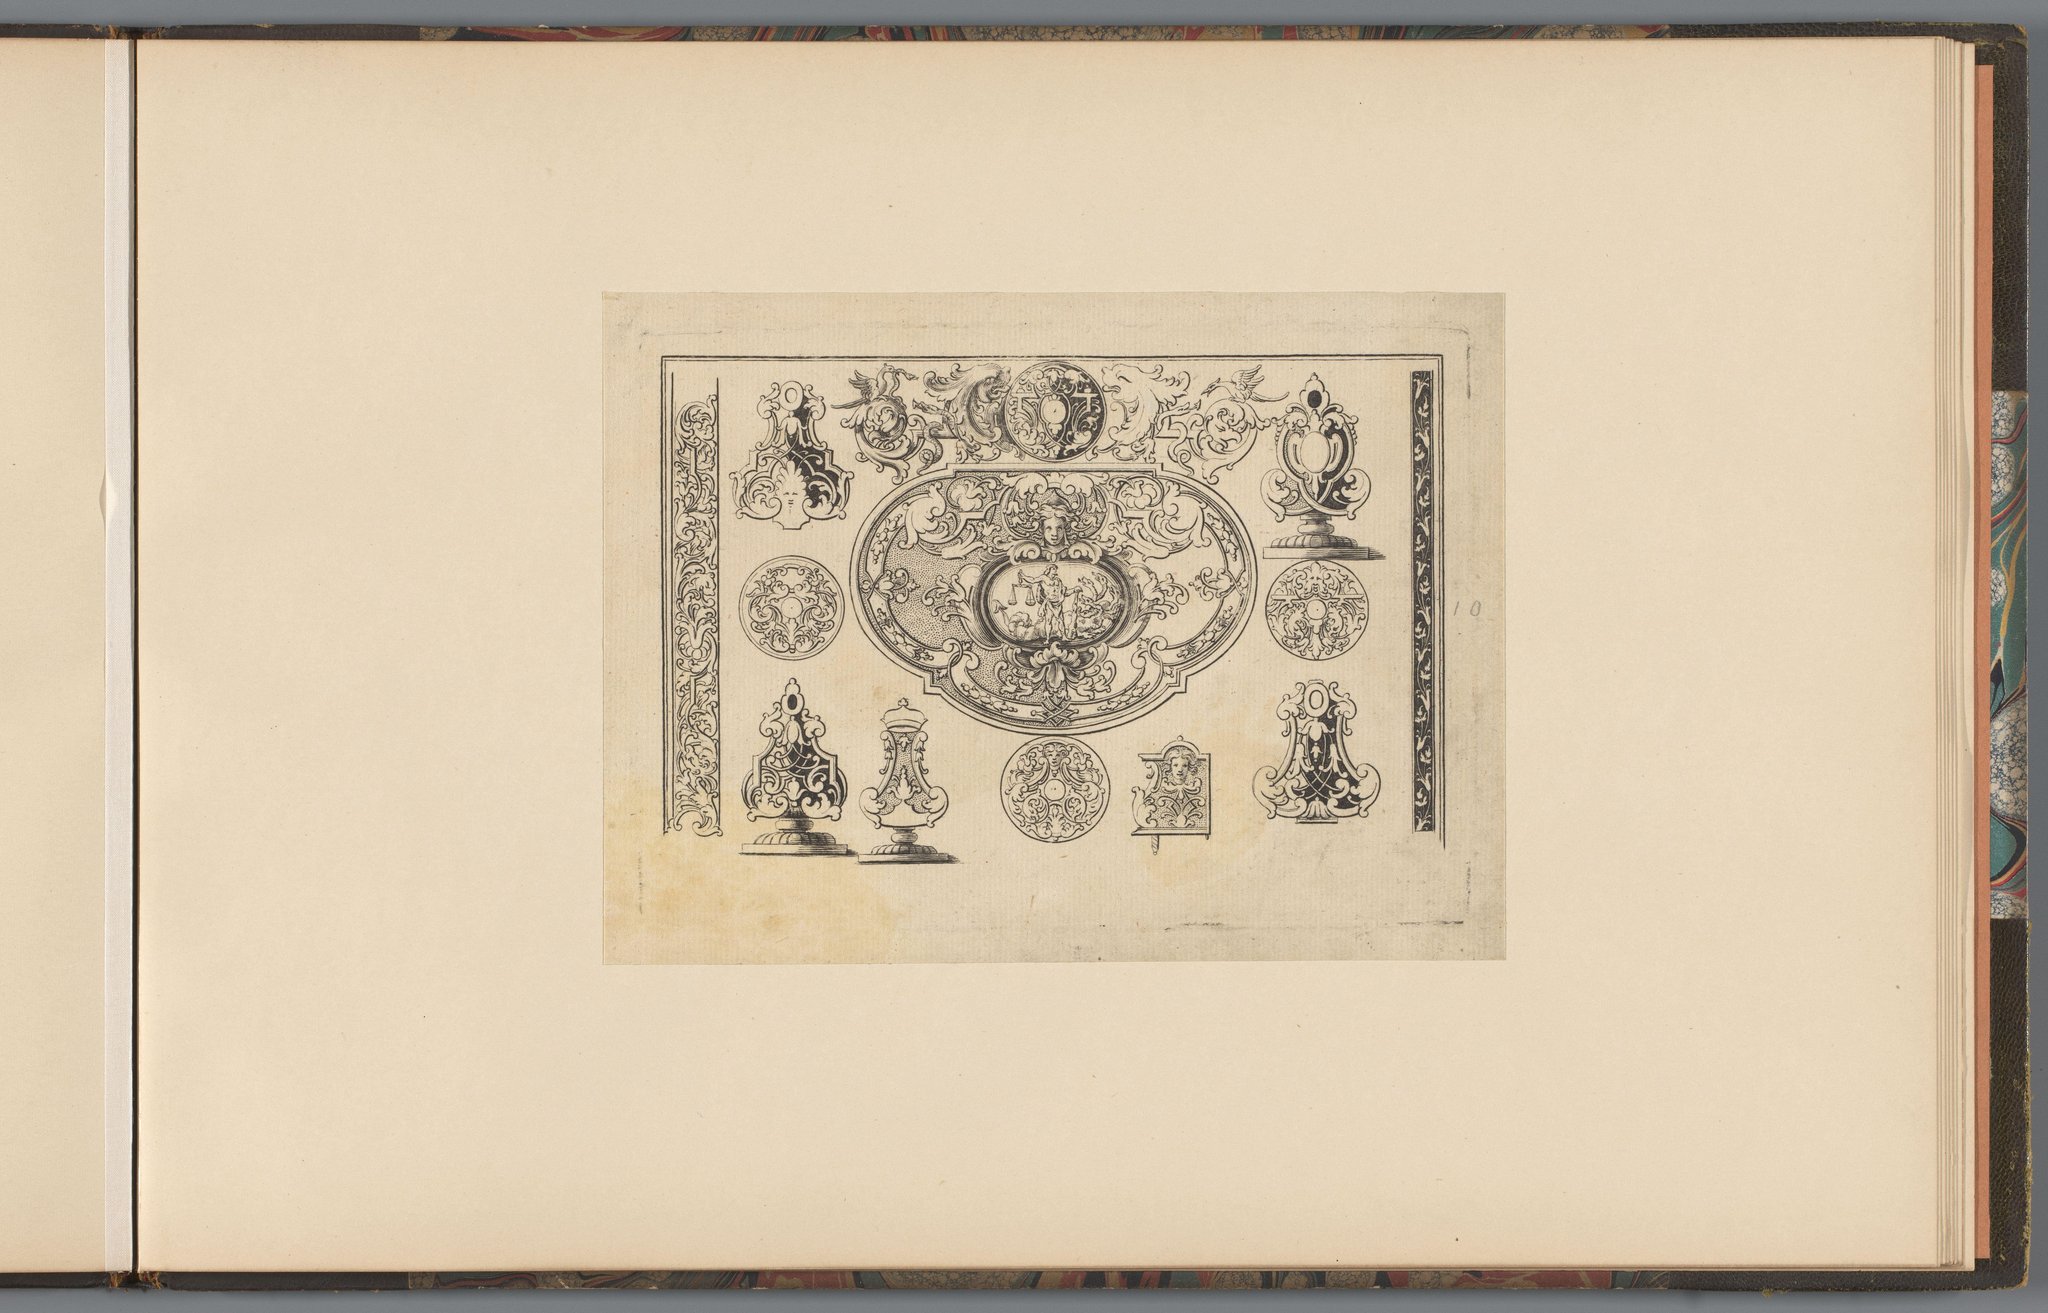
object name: album leaf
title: ontwerpen voor deksels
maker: johann lorenz hönnig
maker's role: print maker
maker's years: 1674-1713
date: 1707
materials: paper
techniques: engraving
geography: nuremberg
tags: ornaments ~ art, snuff-box, (2) the hydra of lerna is killed by hercules, most important deeds of hercules: the twelve labours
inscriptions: number: ‘10’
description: In het midden een ontwerp voor een deksel van een snuifdoos met daarop afgebeeld Herakles die de Hydra van Lerna verslaat. Deze snuifdoos wordt omringd door mogelijk ontwerpen voor handvaten van deksels van potten. Zwartornamenten. Prent maakt deel uit van een album.